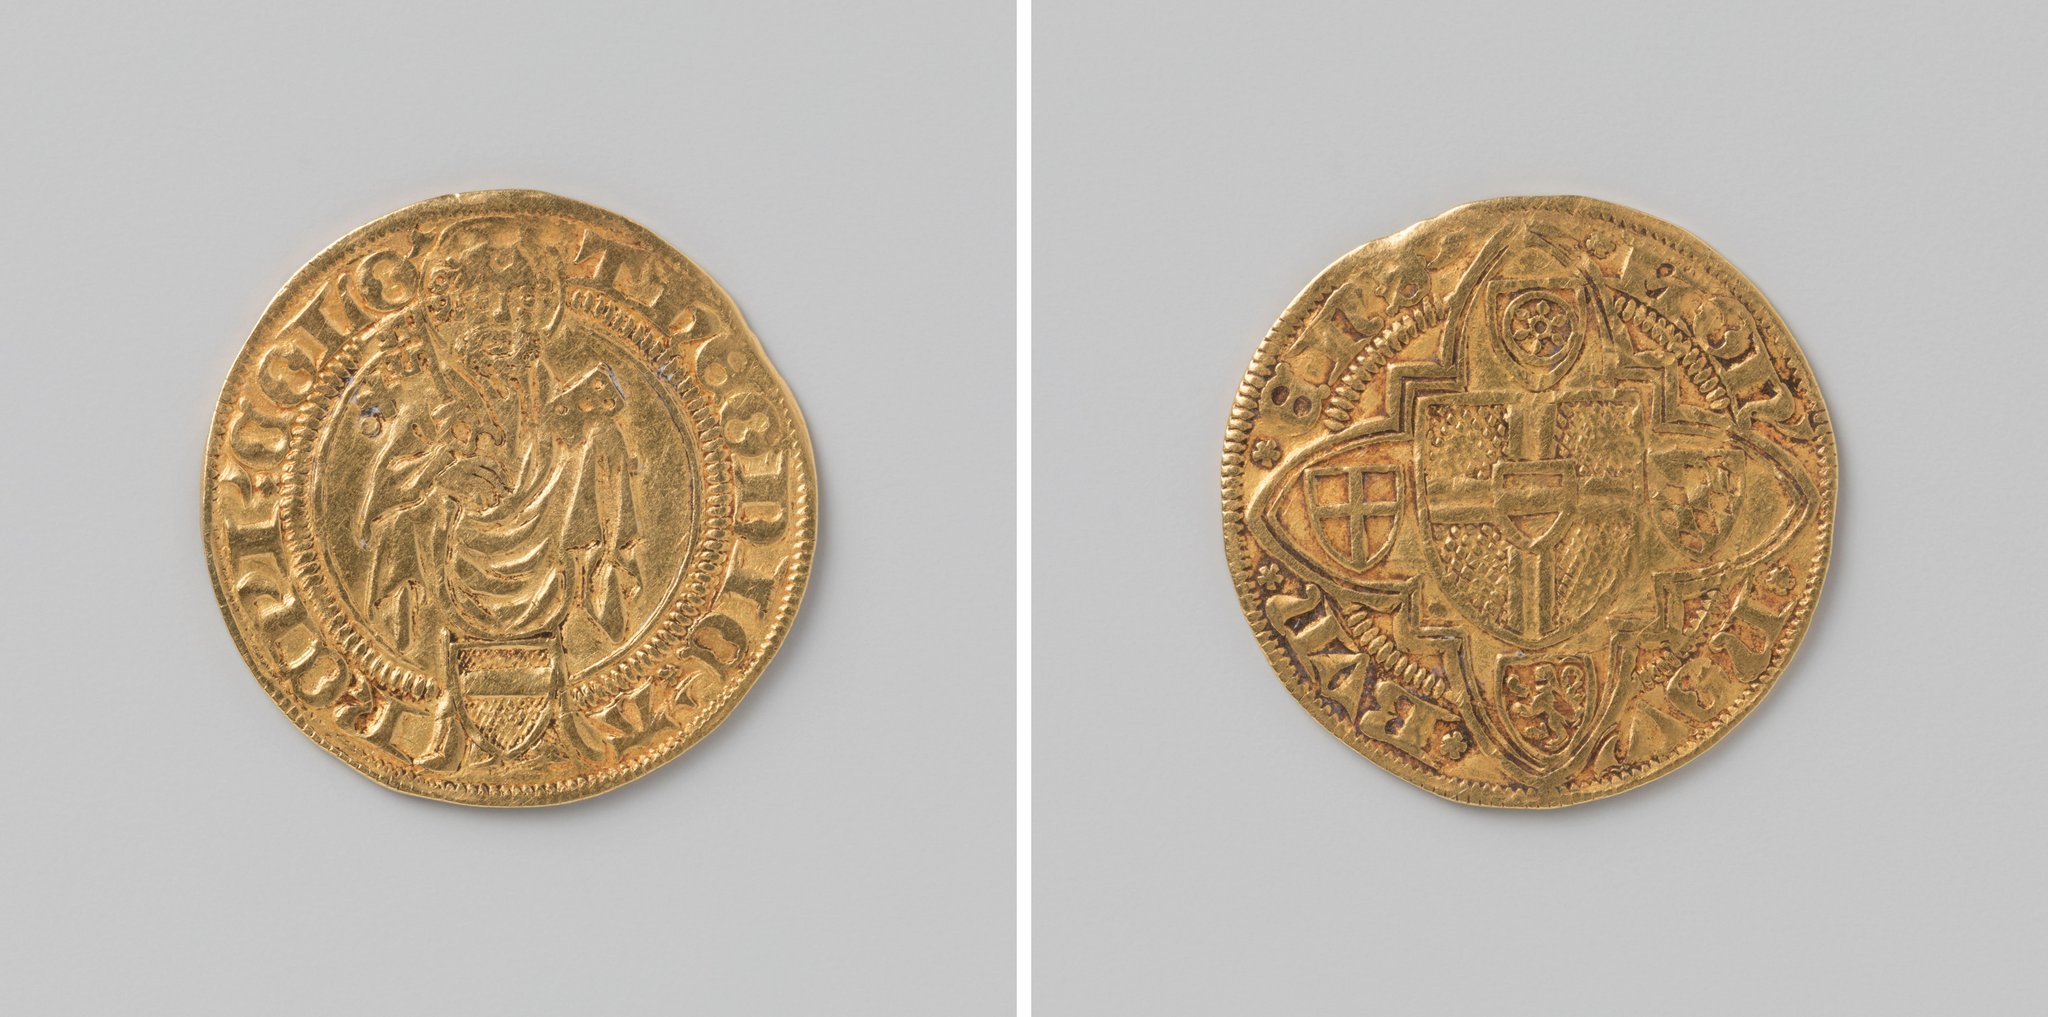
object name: rijnsgulden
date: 1420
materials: gold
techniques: striking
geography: bonn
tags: germany, brielle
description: Opgegraven in de tuin van het in 1557 gestichte Merula-weeshuis te Brielle.